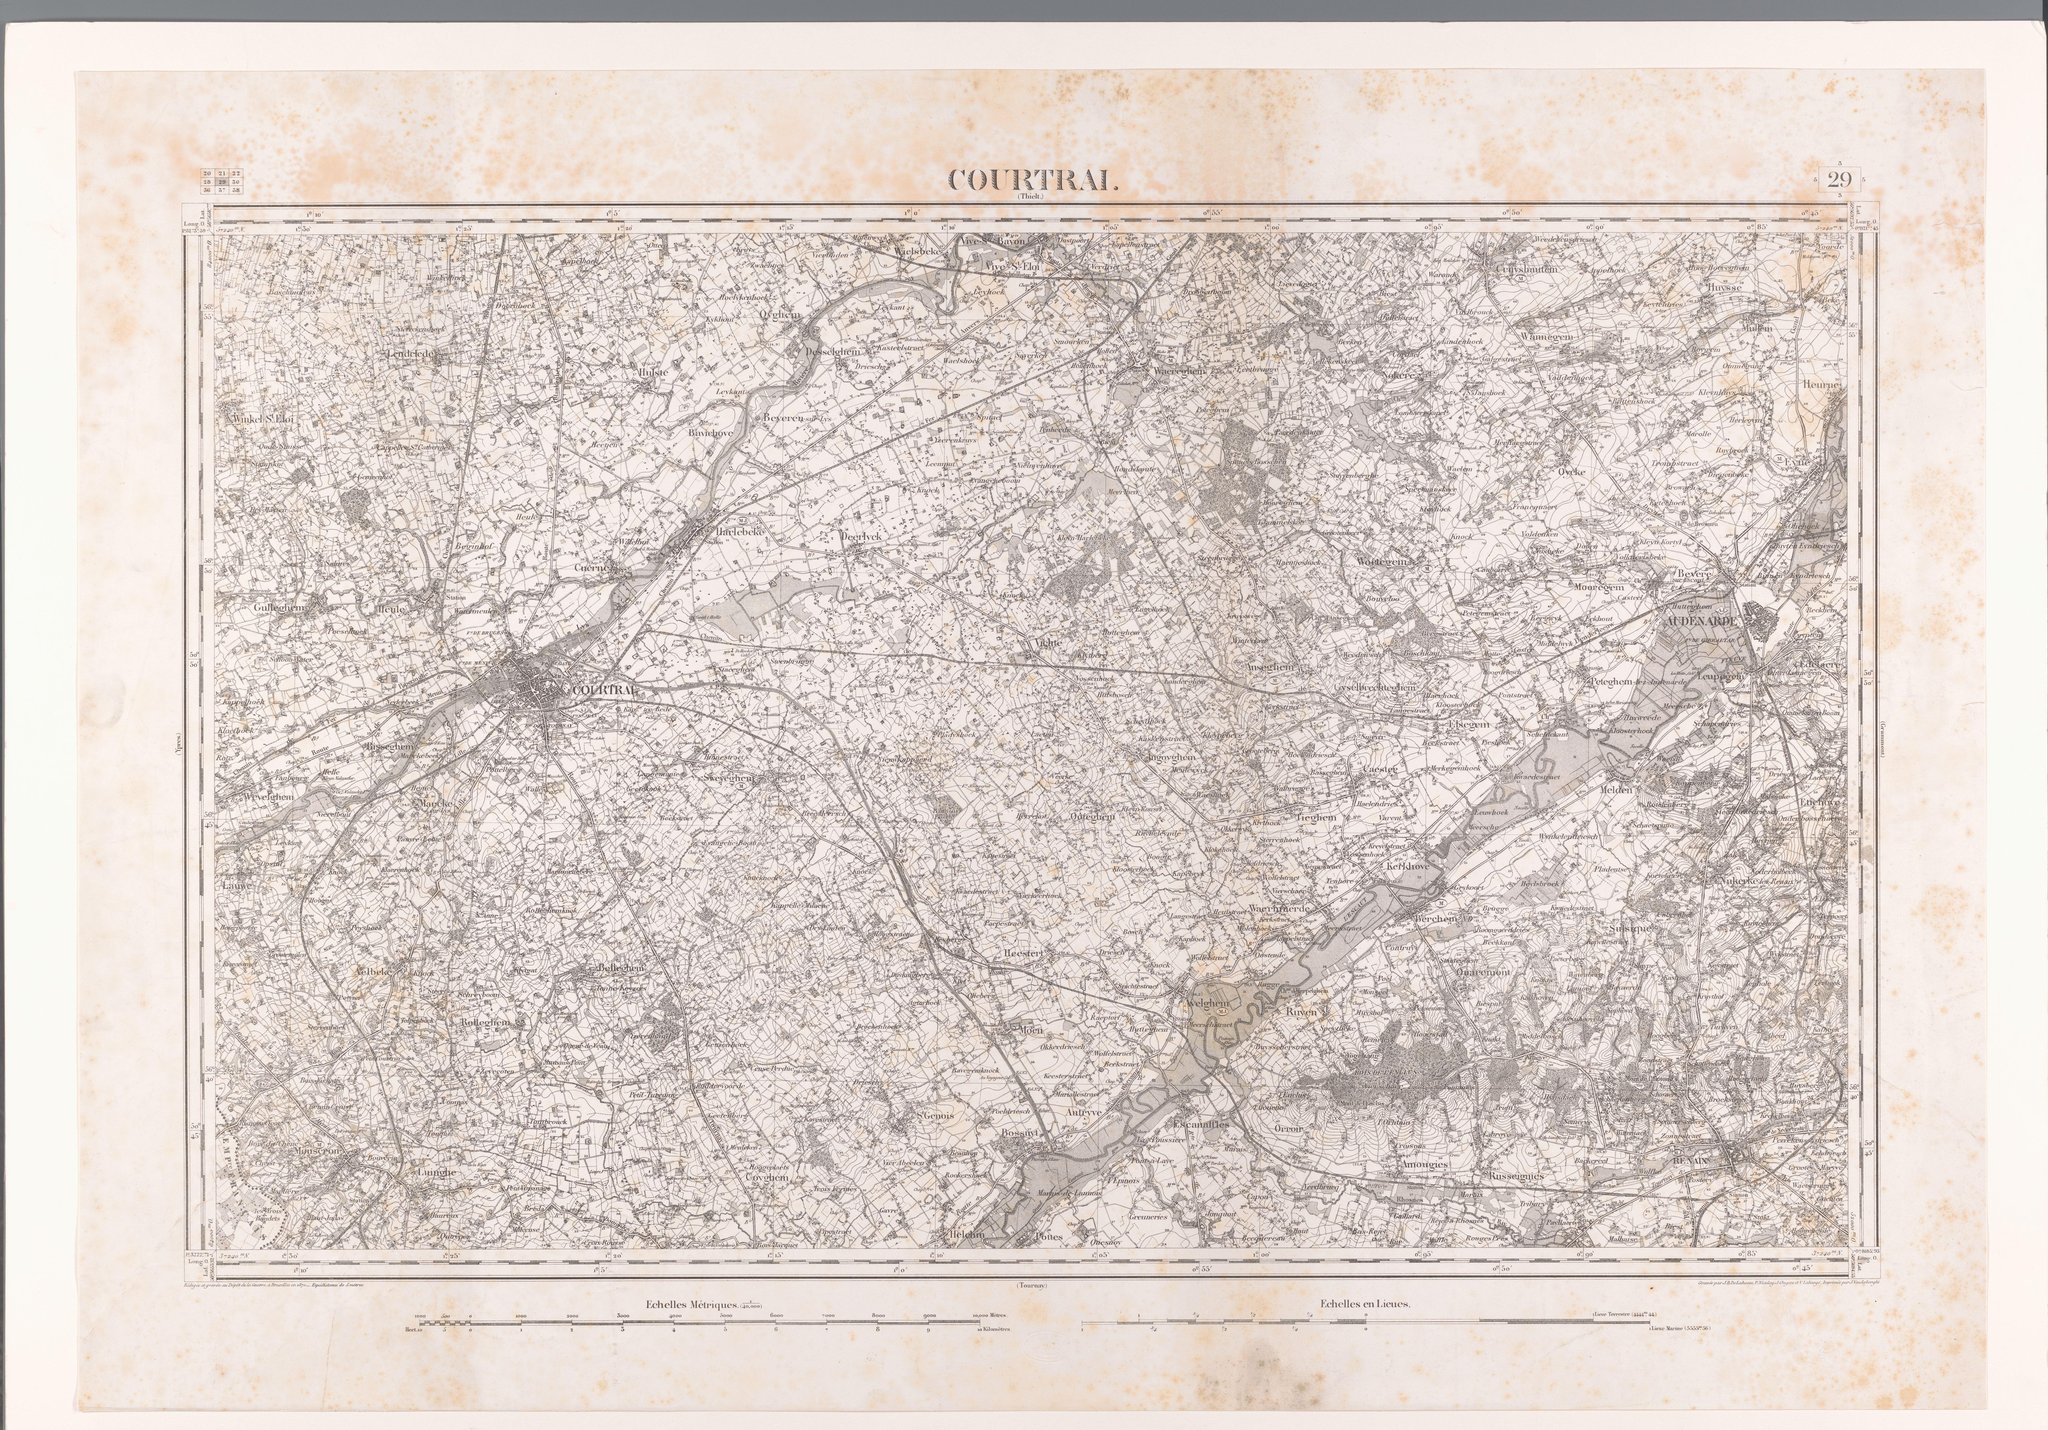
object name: print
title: Courtrai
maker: j. vanderborght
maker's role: printer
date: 1870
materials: paper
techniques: lithograph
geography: brussels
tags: maps of separate countries or regions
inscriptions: check stamp: ‘Depot de la Guerre Belgique’